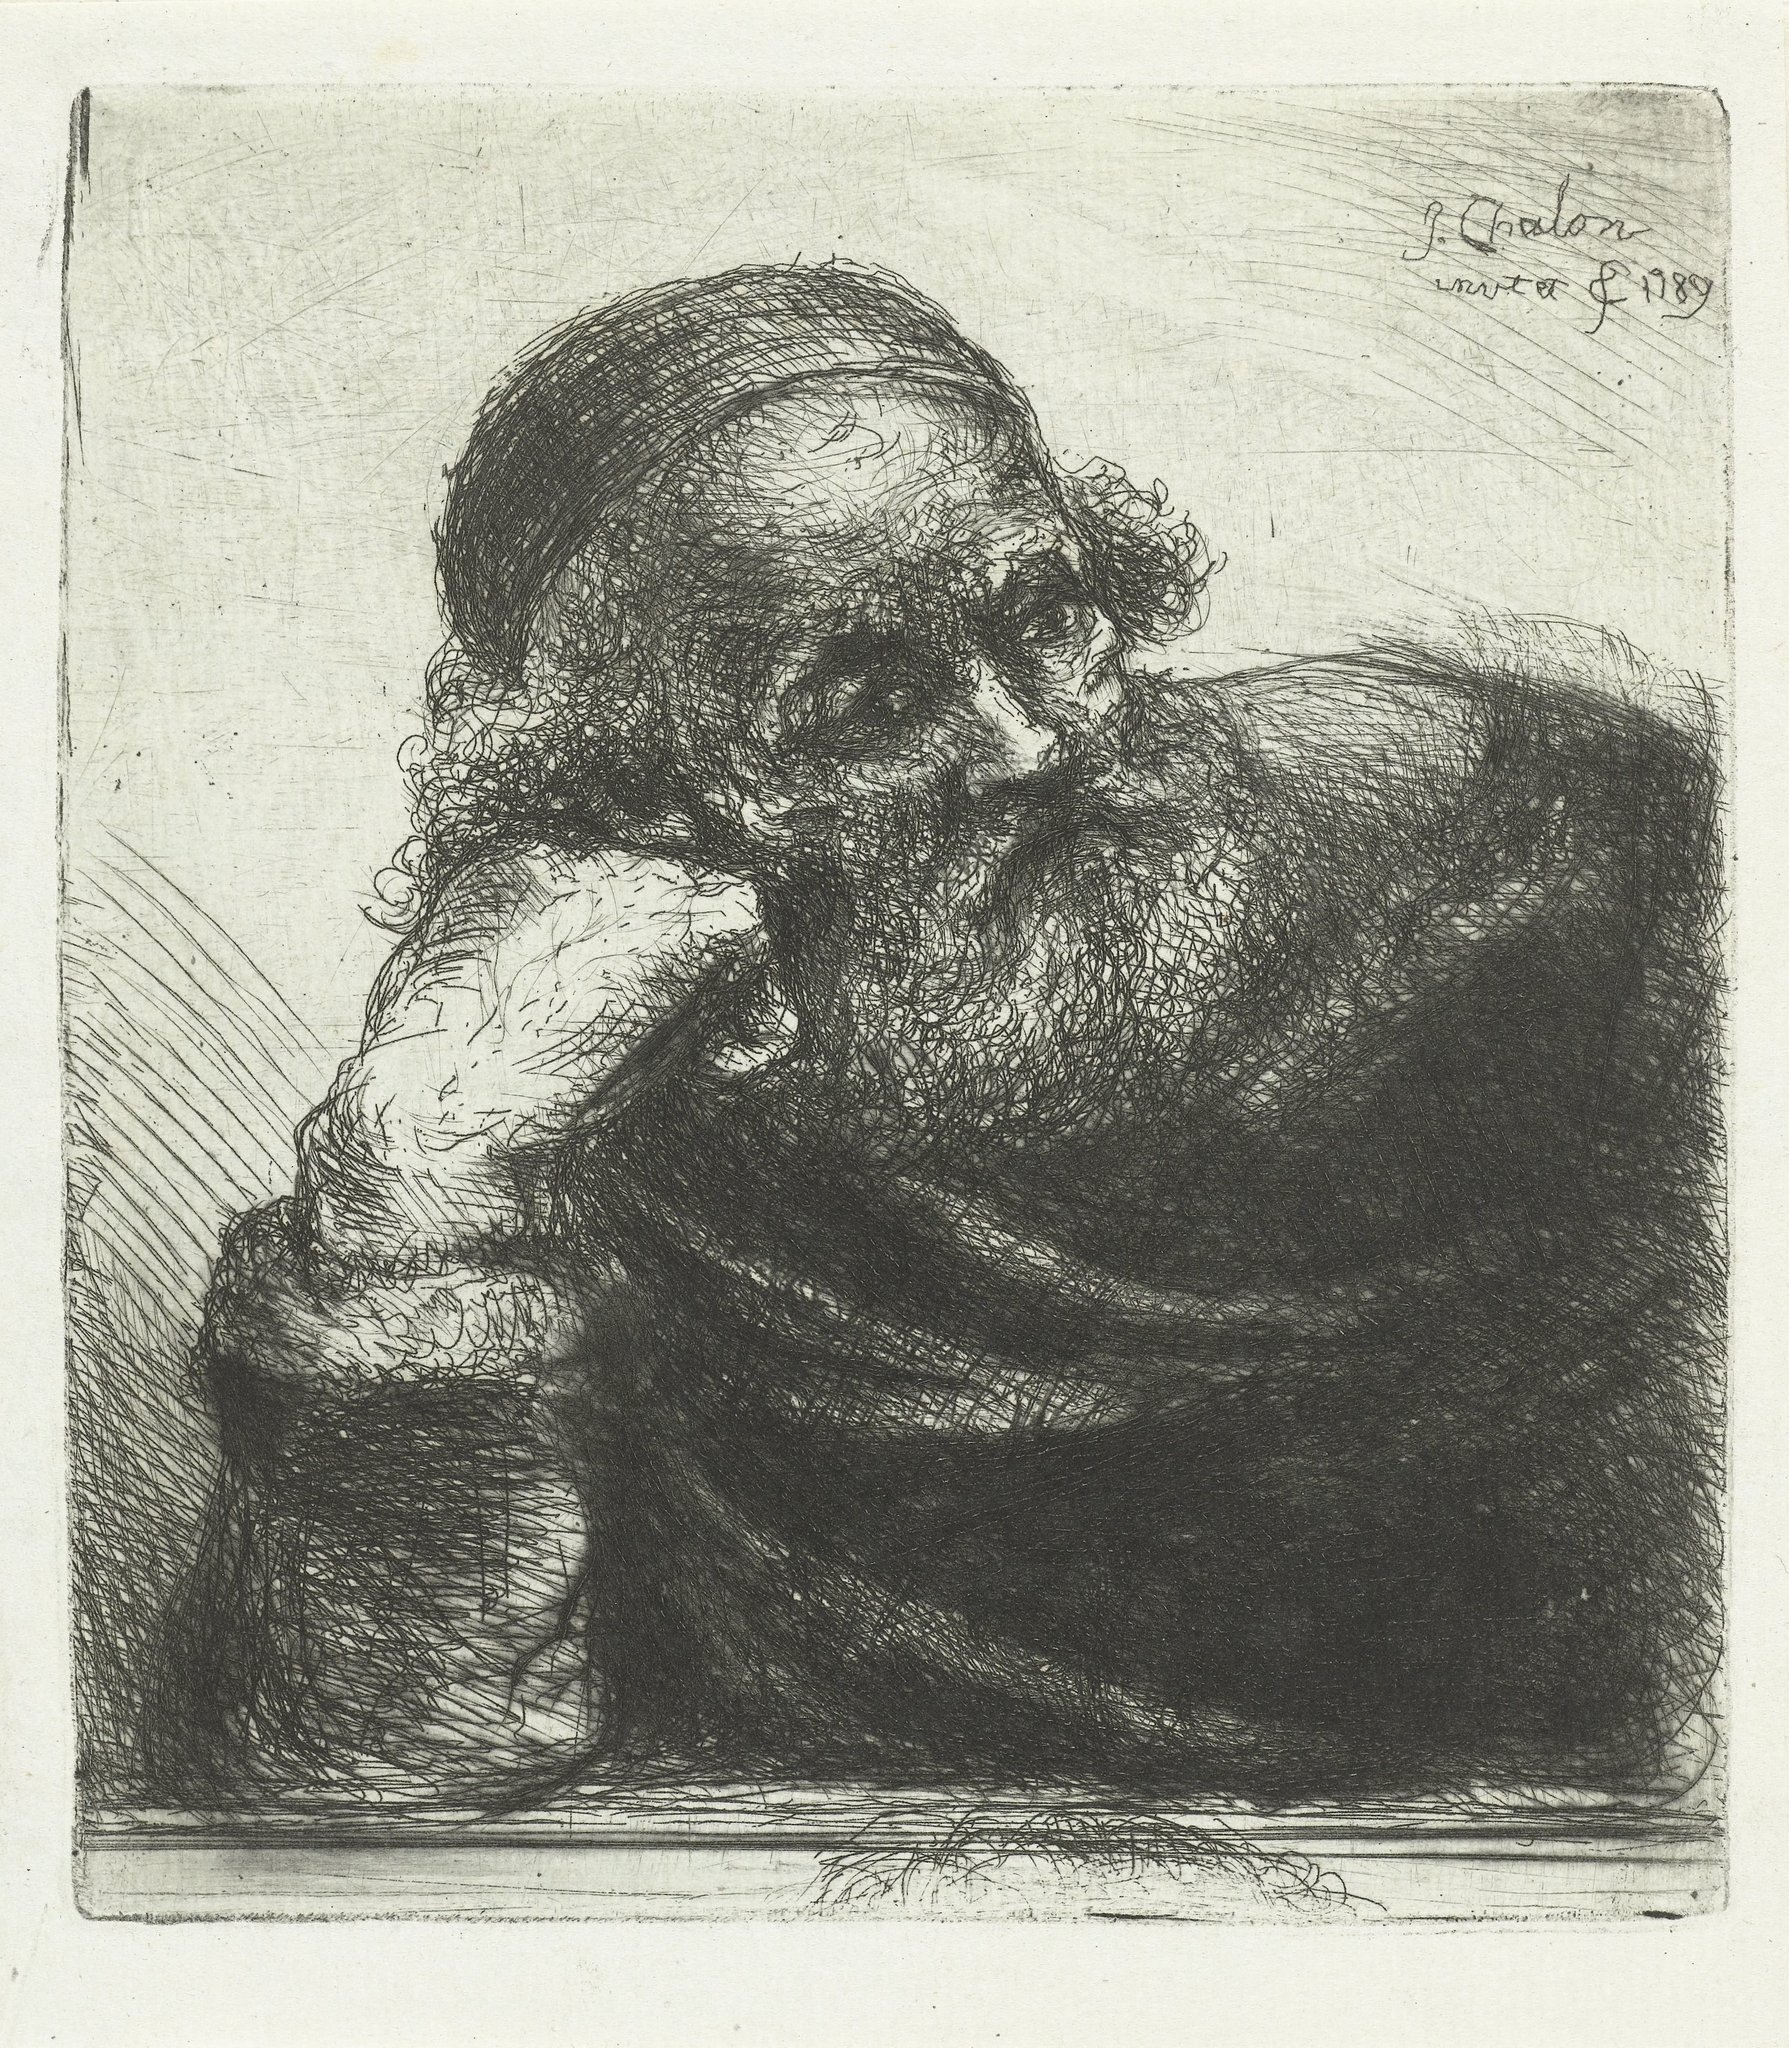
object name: print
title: Oude man, steunend op zijn rechterarm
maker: jan chalon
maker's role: print maker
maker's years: 1738-1795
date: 1789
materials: paper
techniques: drypoint, etching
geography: northern netherlands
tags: head-gear: cap (+ men's clothes), morphology of human expression (+ old male (human being))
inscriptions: collector's mark: Lugt 2228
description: Het portret is van een oude man met een baard en een muts. Buste naar rechts. Hij ondersteunt zijn hoofd met zijn rechterarm.